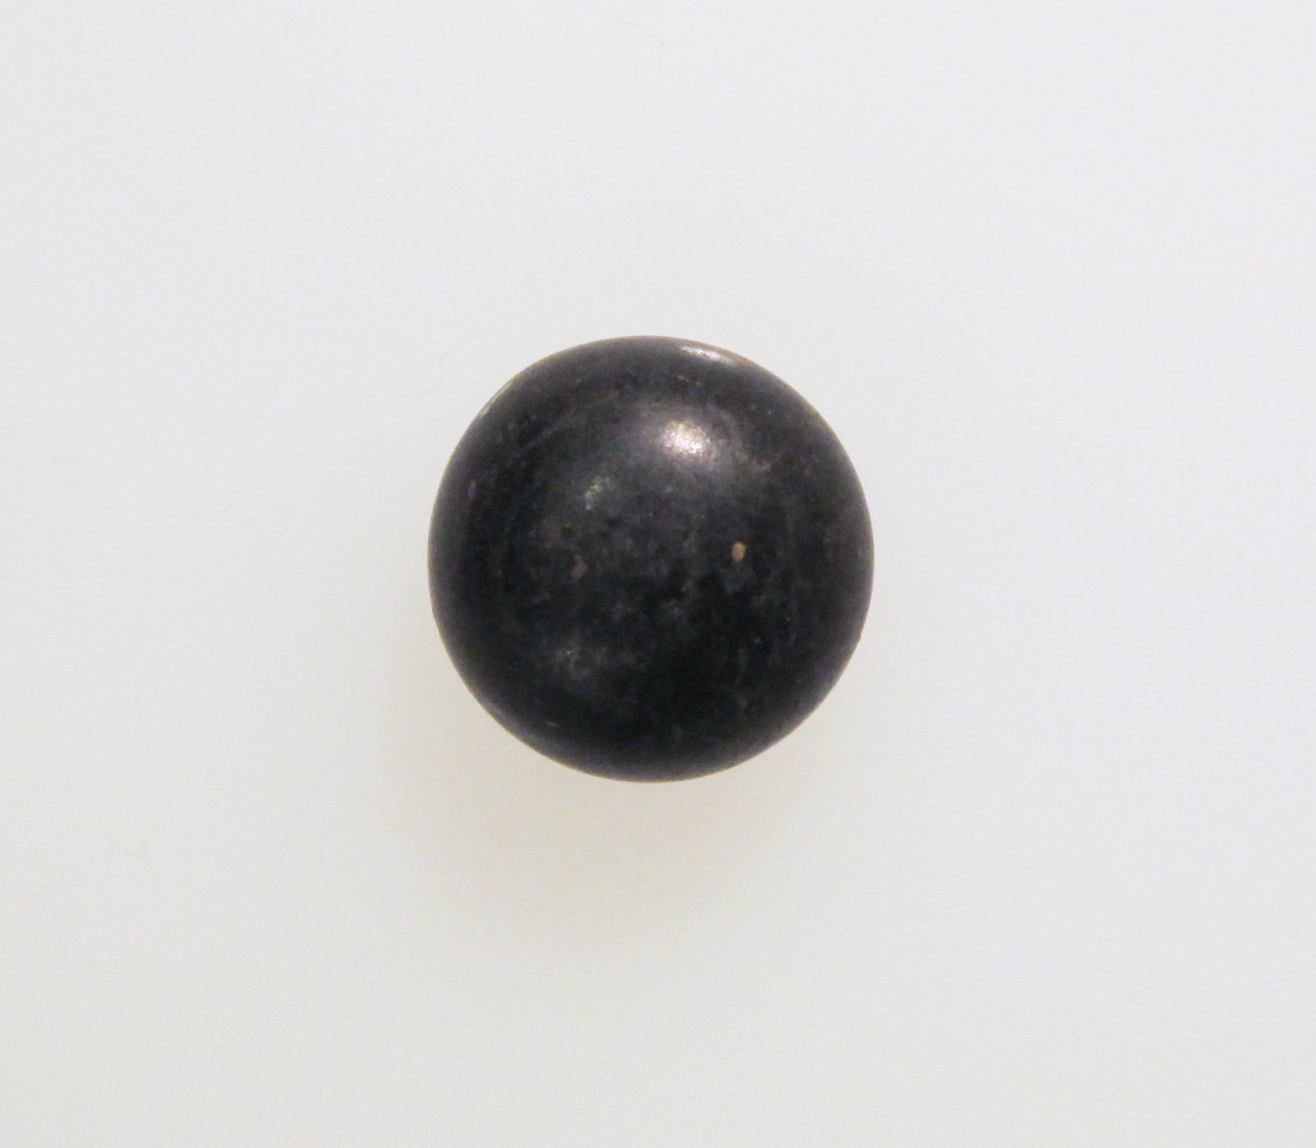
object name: pinhead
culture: roman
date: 100 BCE-500 CE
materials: glass